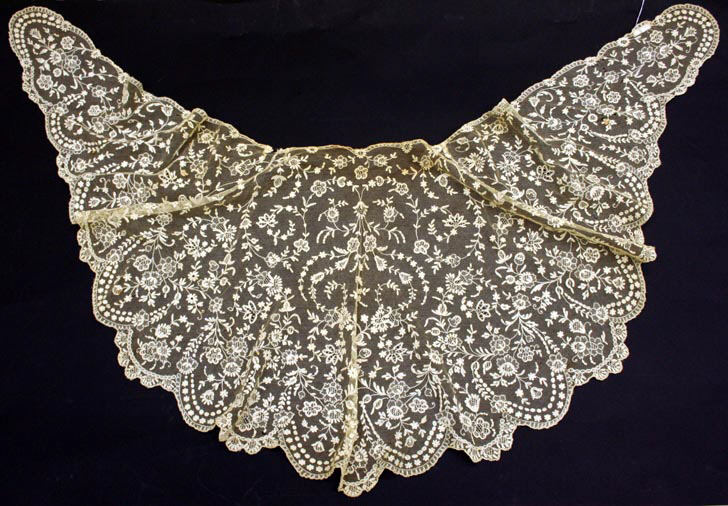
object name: pelerine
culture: american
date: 1830-1839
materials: cotton